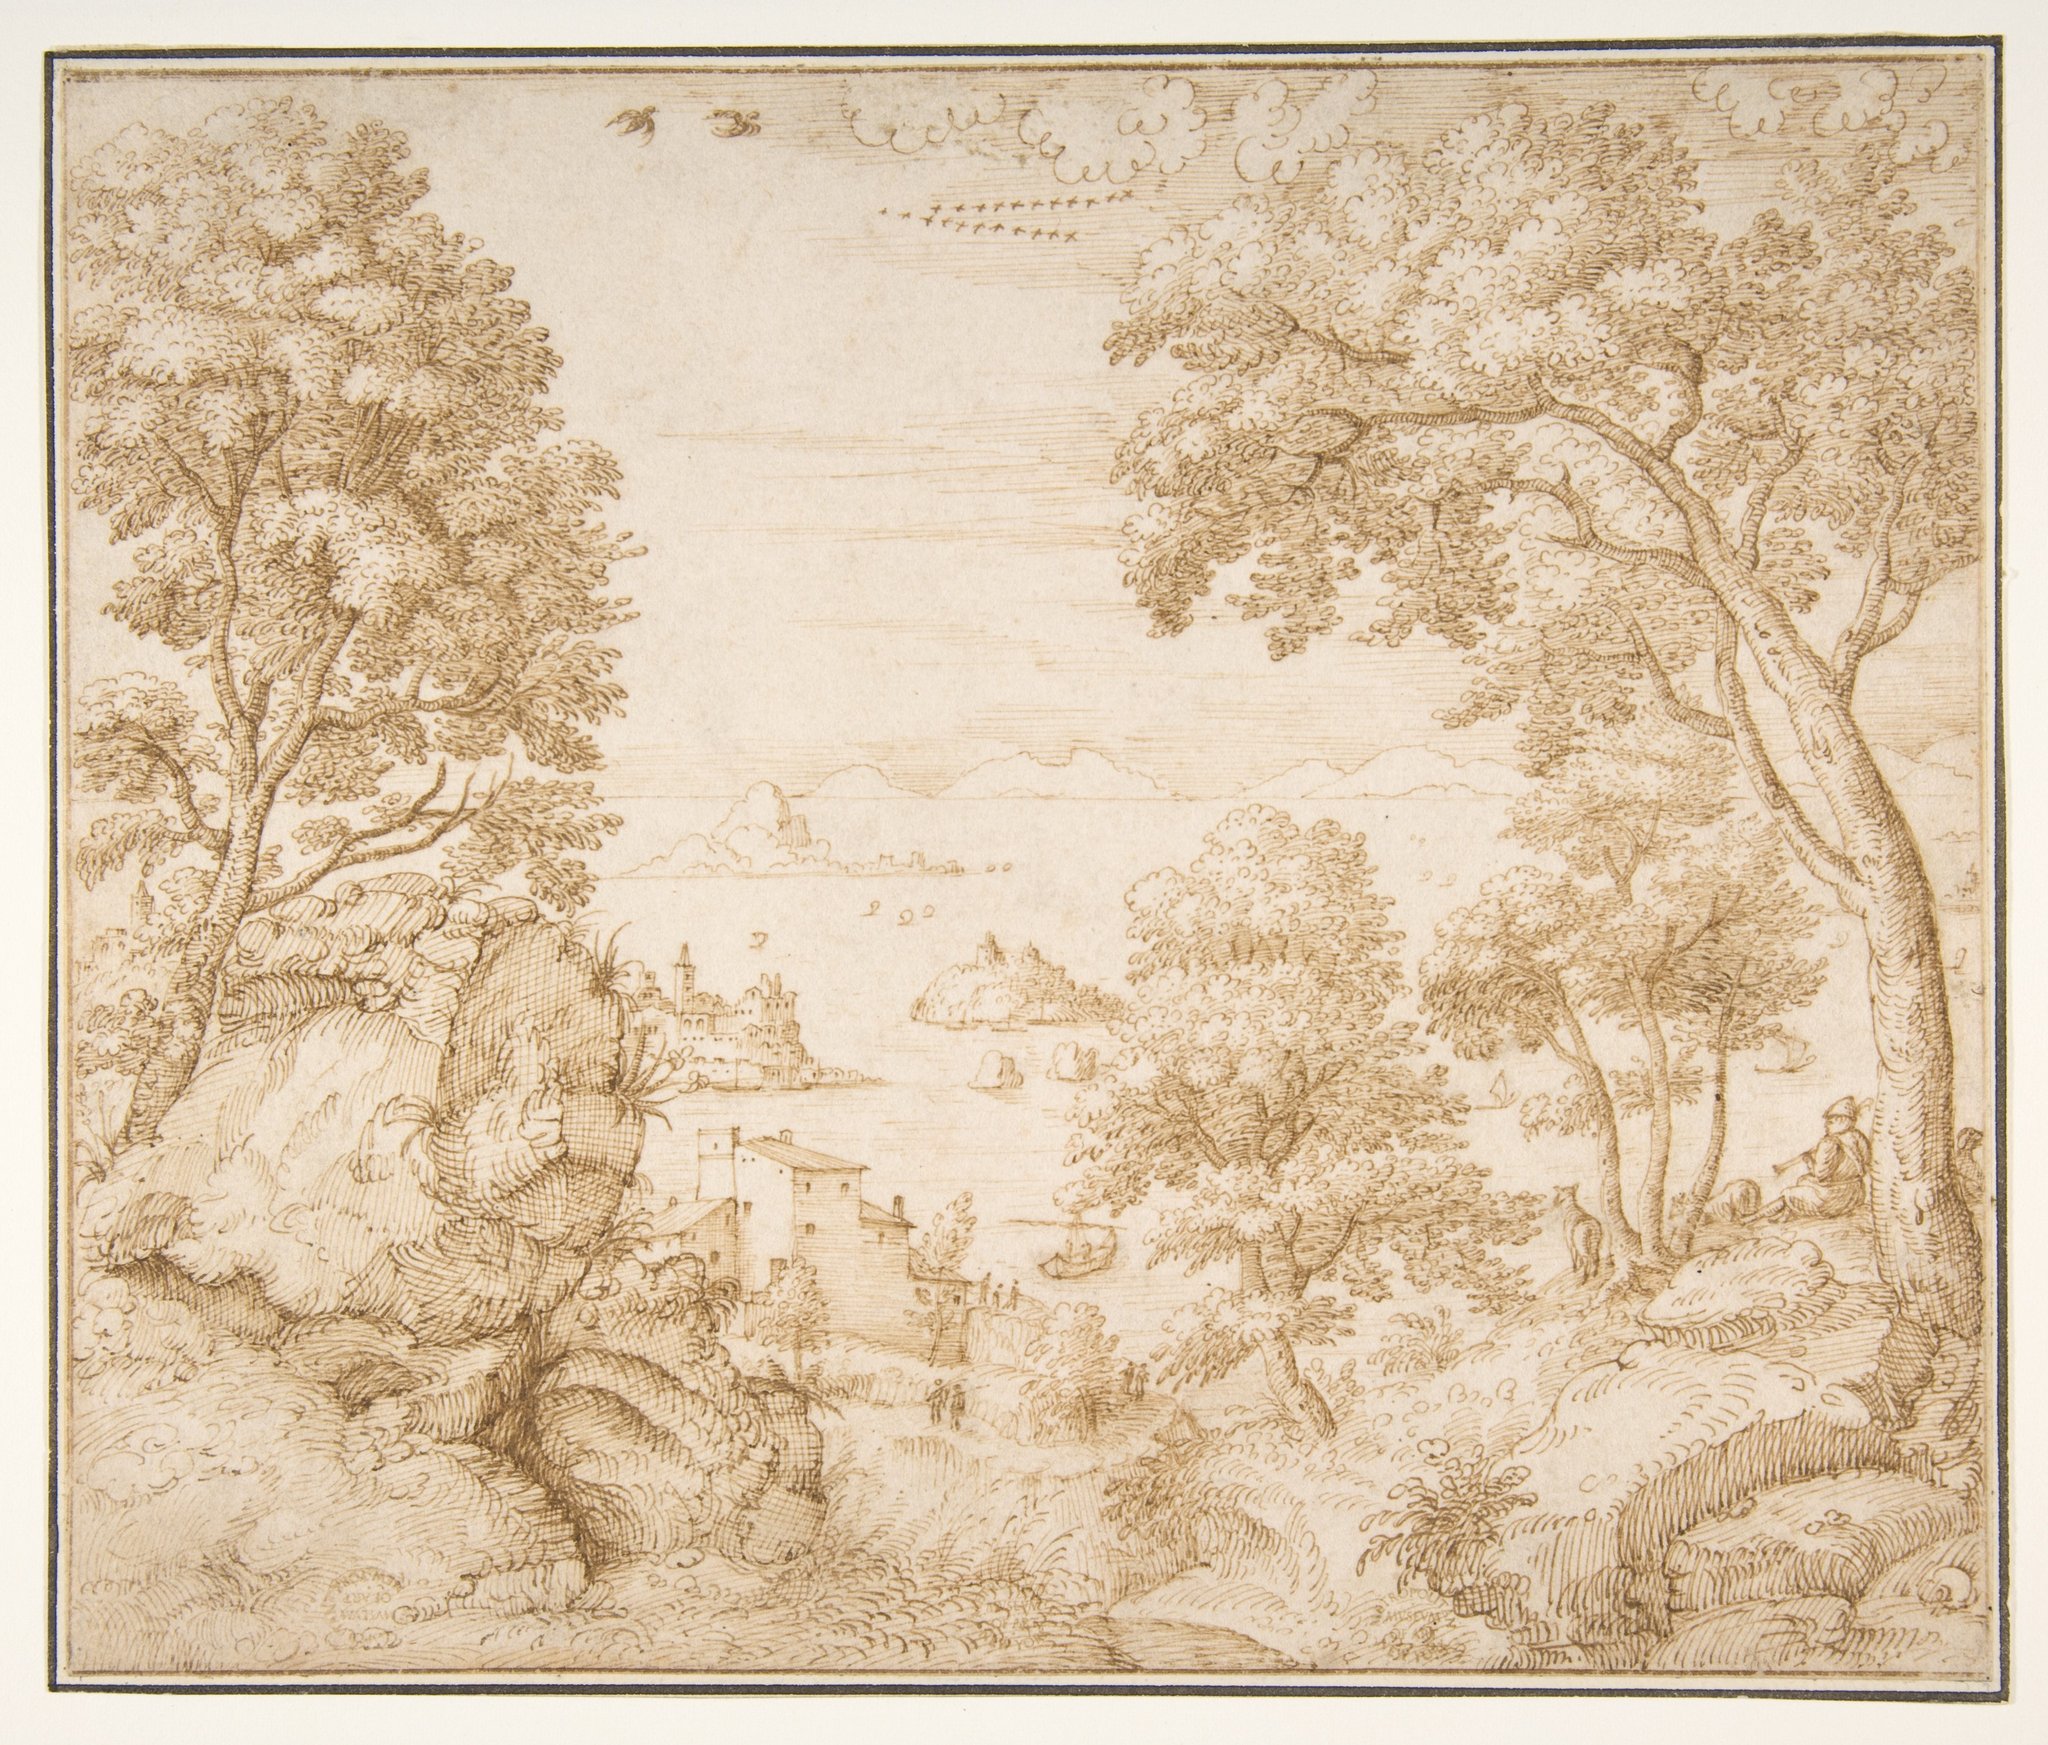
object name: drawing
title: Coastal Landscape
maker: gherardo cibo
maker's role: artist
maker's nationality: italian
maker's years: 1512-1600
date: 1512-1600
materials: ink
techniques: pen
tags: human figures,animals,houses,landscapes,trees